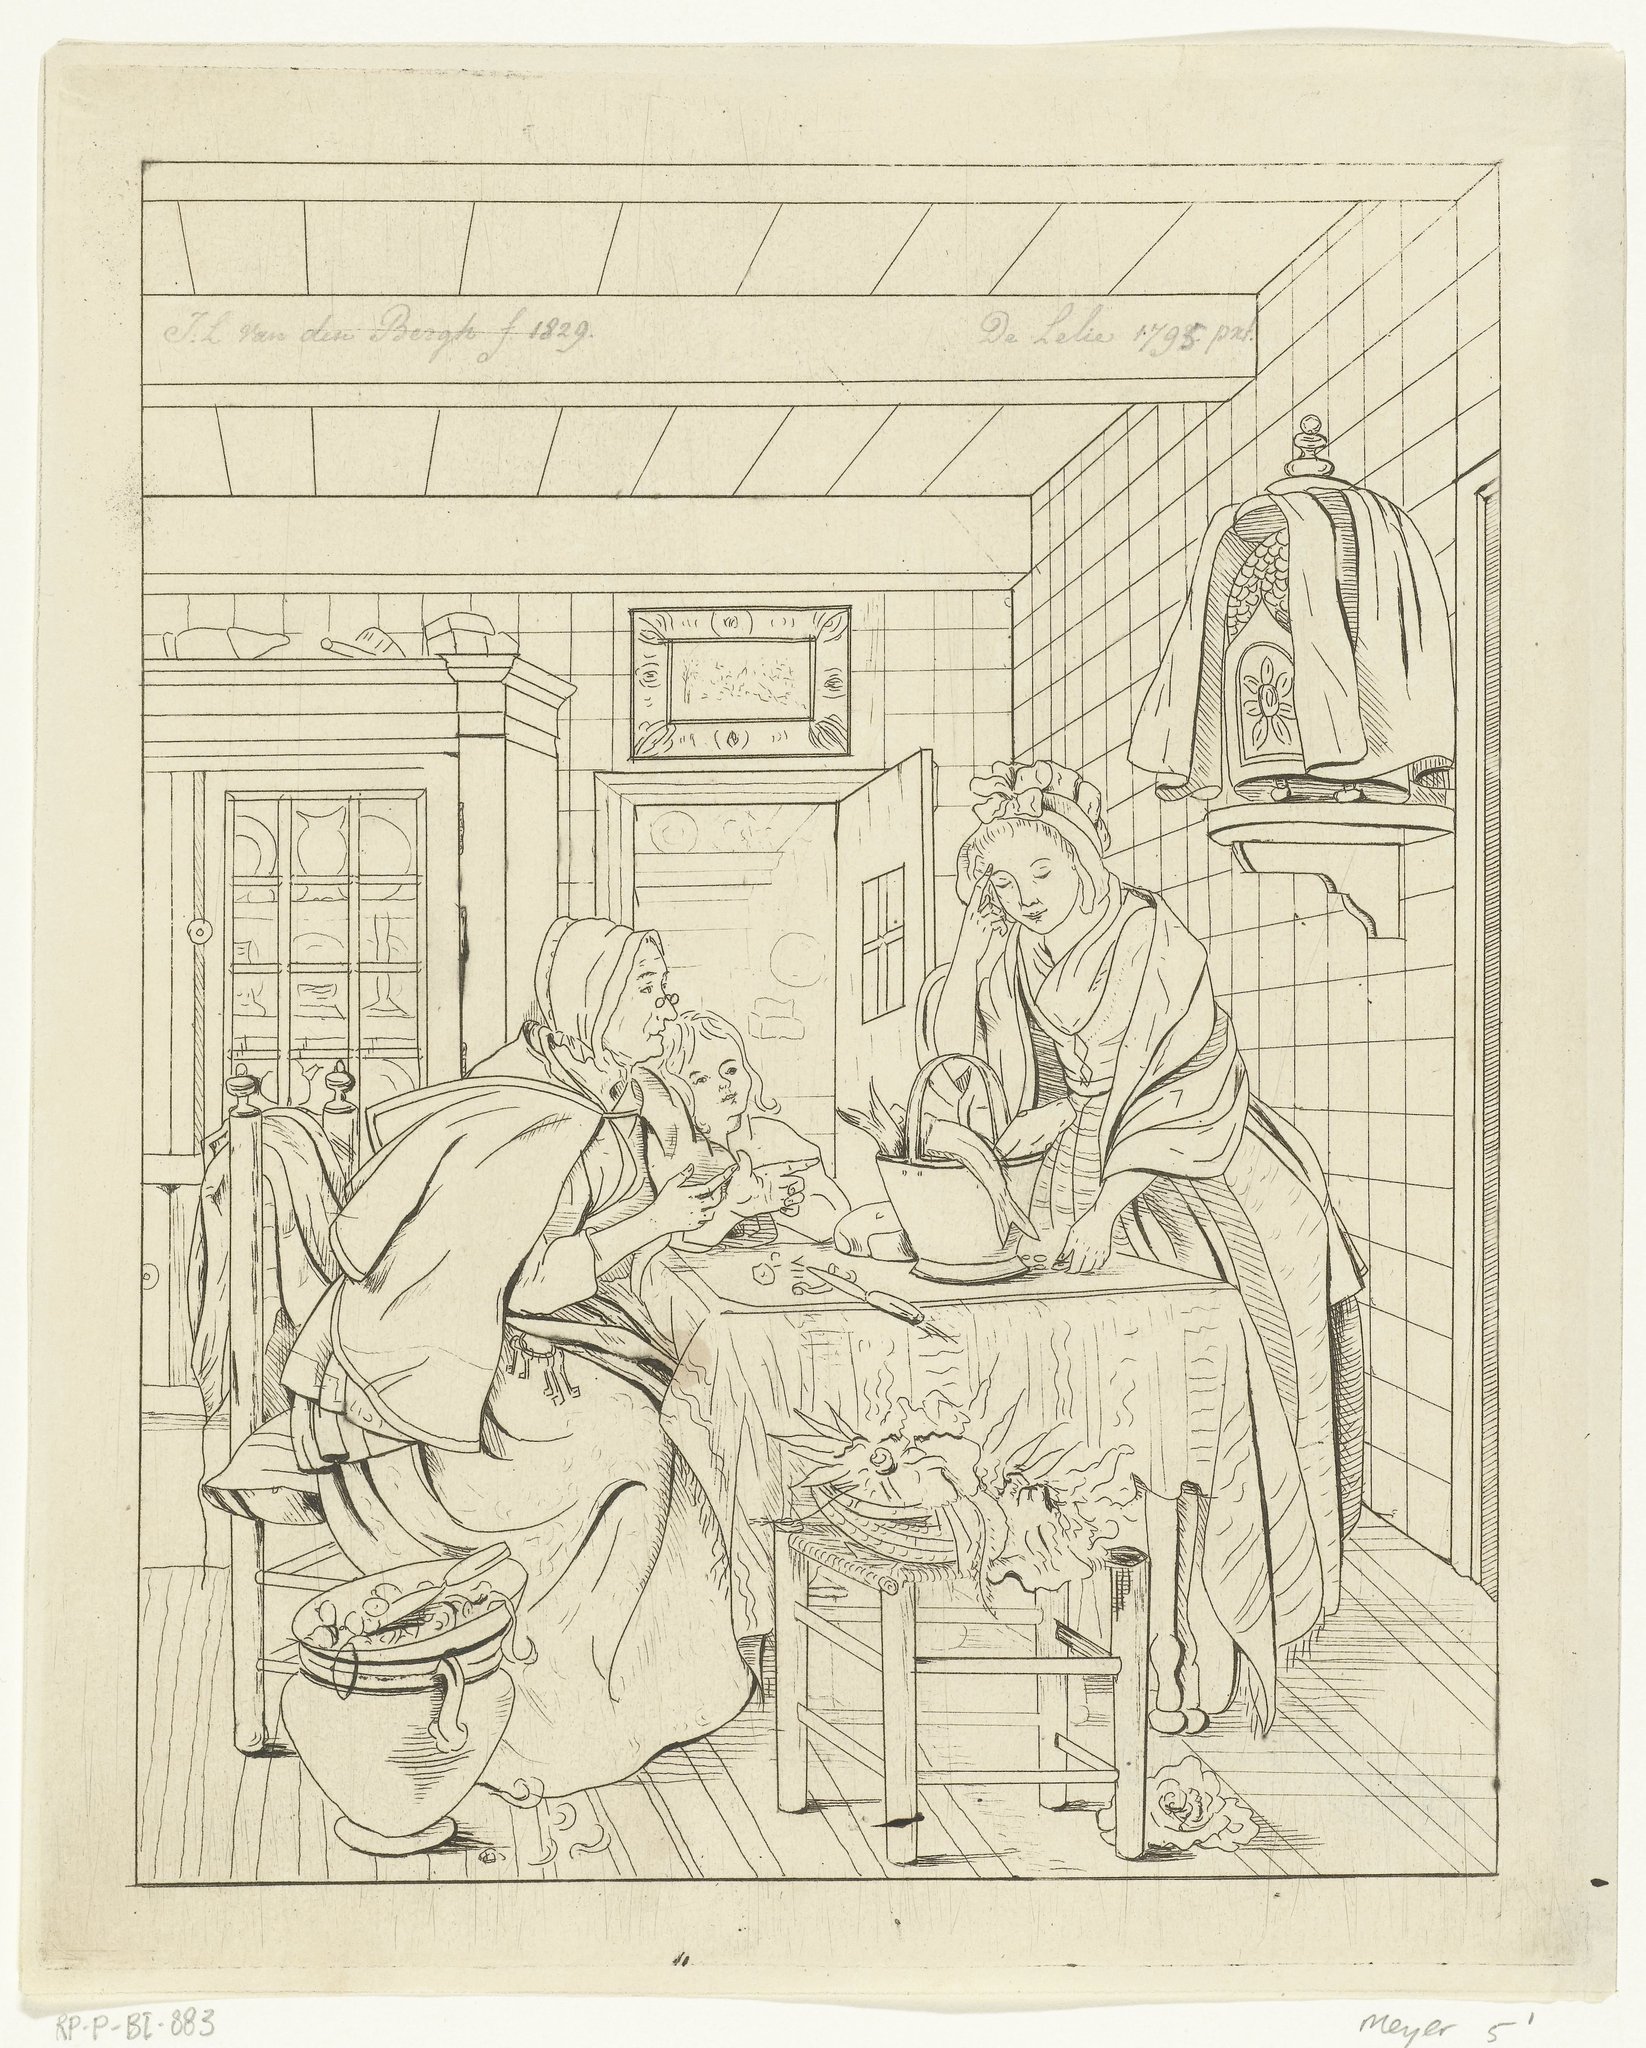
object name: print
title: Dienstmeid met boodschappen bij oude vrouw in keuken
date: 1829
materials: paper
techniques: etching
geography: netherlands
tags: kitchen, house personnel, servants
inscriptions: collector's mark: Lugt 2228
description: Dienstmeid heeft verse vis gehaald en telt het geld dat ze nog heeft voor oude vrouw aan tafel in keuken.